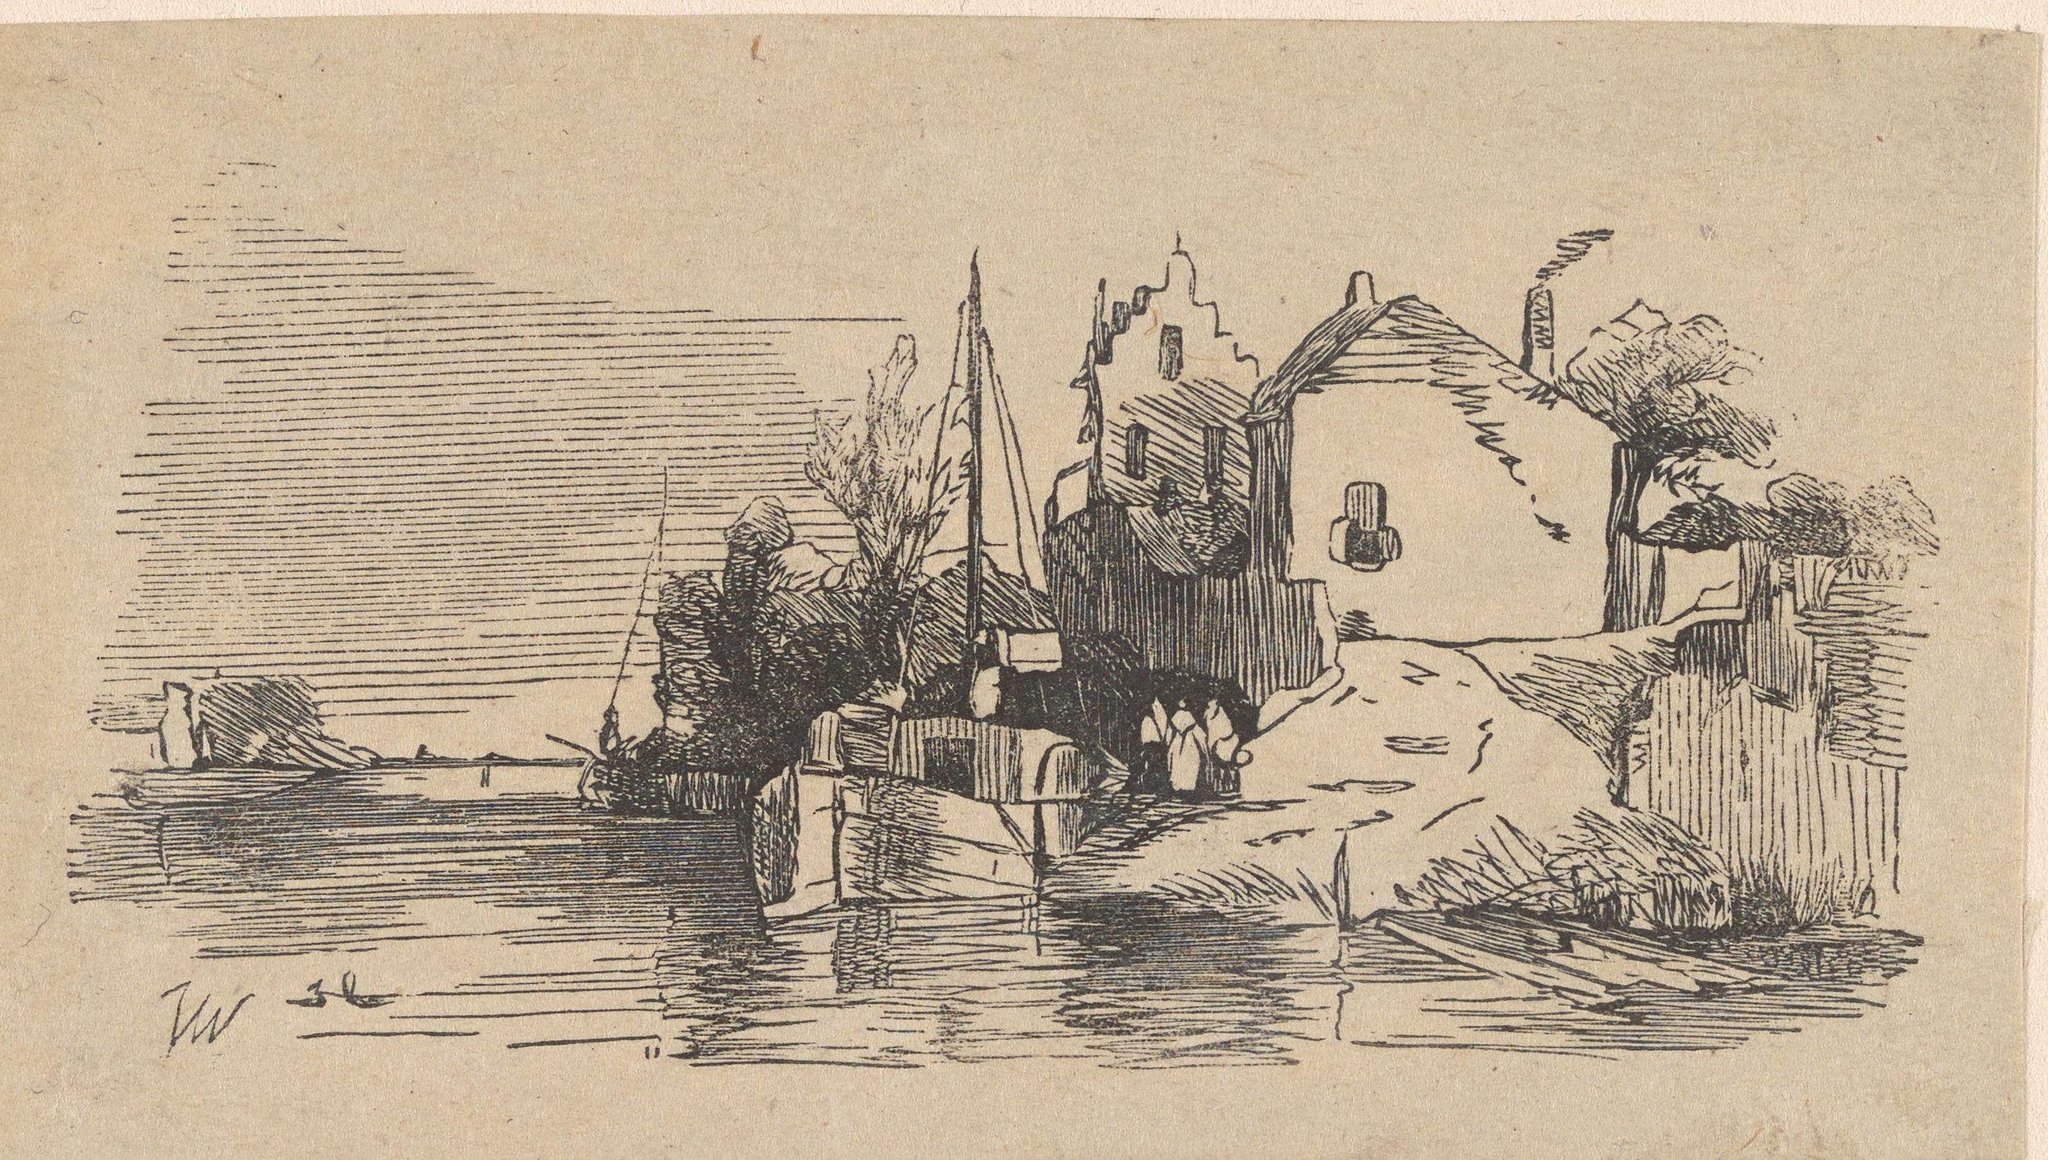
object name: print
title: Rivierlandschap met een aantal schepen en huizen aan het water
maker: isaac weissenbruch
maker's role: print maker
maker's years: 1826-1912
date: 1836-1912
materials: paper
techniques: engraving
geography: netherlands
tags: sailing-ship, sailing-boat, river, farm or solitary house in landscape